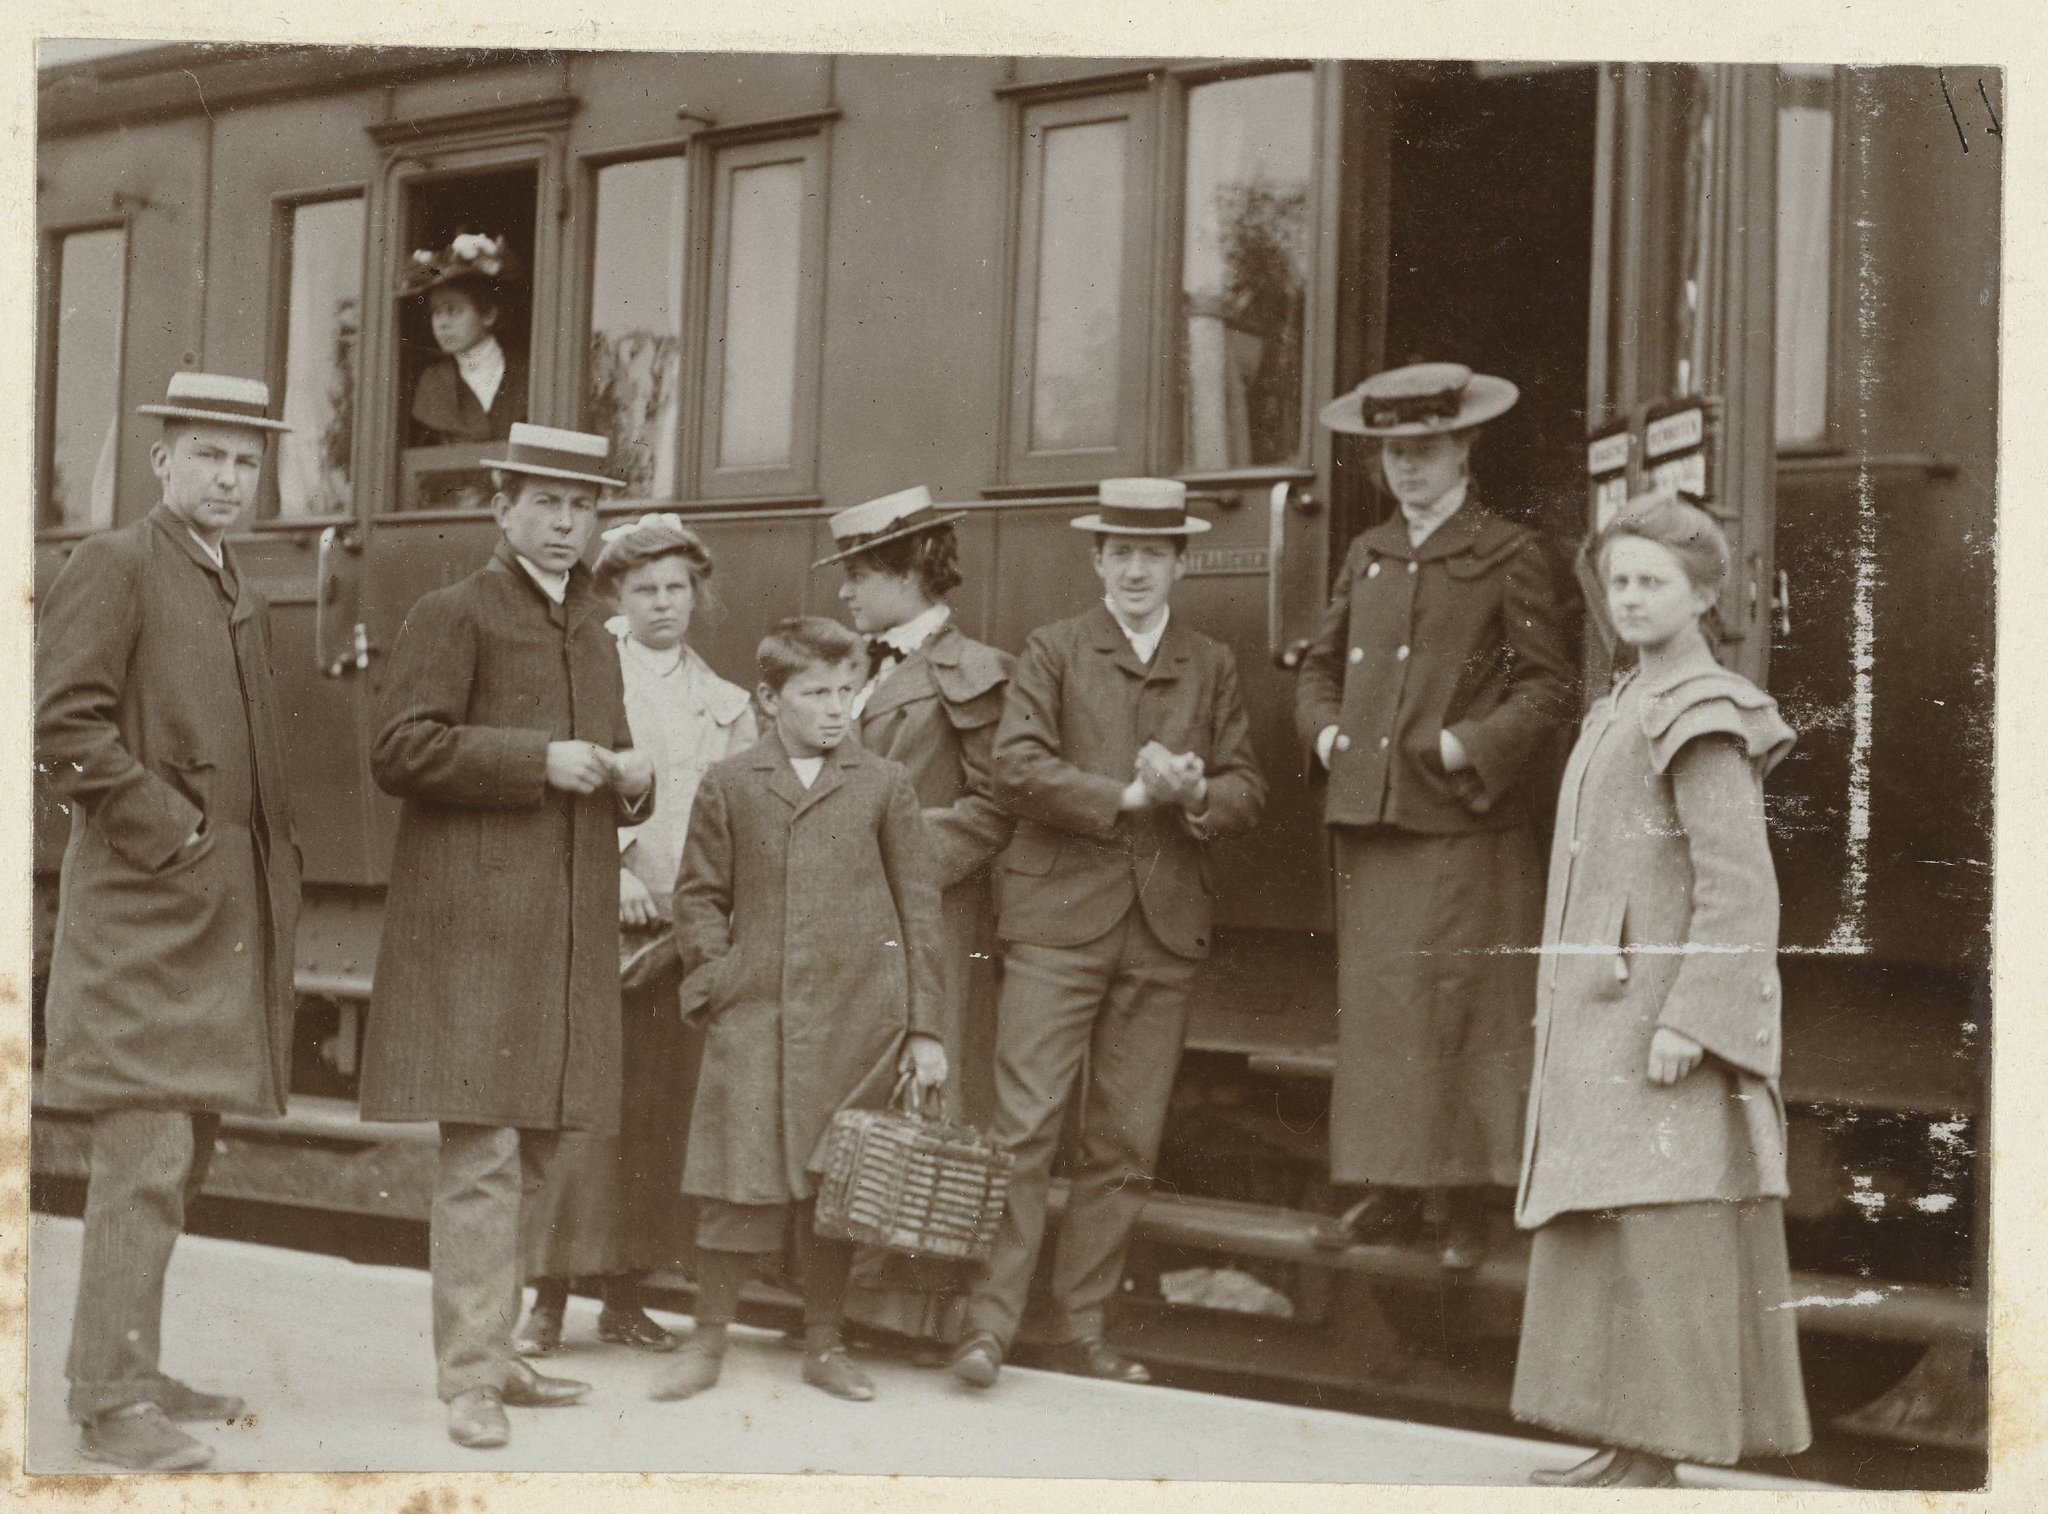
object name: photograph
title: Groepsportret met Go, Dolph en Jan Kessler bij het vertrek met de trein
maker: geldolph adriaan kessler (dolph)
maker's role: fotograaf, industrieel, voetballer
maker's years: 1884-1945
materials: cardboard, photographic support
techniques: collodion silver print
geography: netherlands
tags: official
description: Groepsportret bij het vertrek met de trein. Onderdeel van het fotoalbum van Dolph Kessler met opnamen die hij maakte tijdens zijn verblijf in Engeland en op een wereldreis die hij als secretaris van Henri Deterding (directeur Koninklijke Olie) ondernam naar Nederlands-Indië, Japan, China en de Verenigde Staten, tussen 1906 en 1908. Midden op de foto, naast de trein, staat John Heijning.